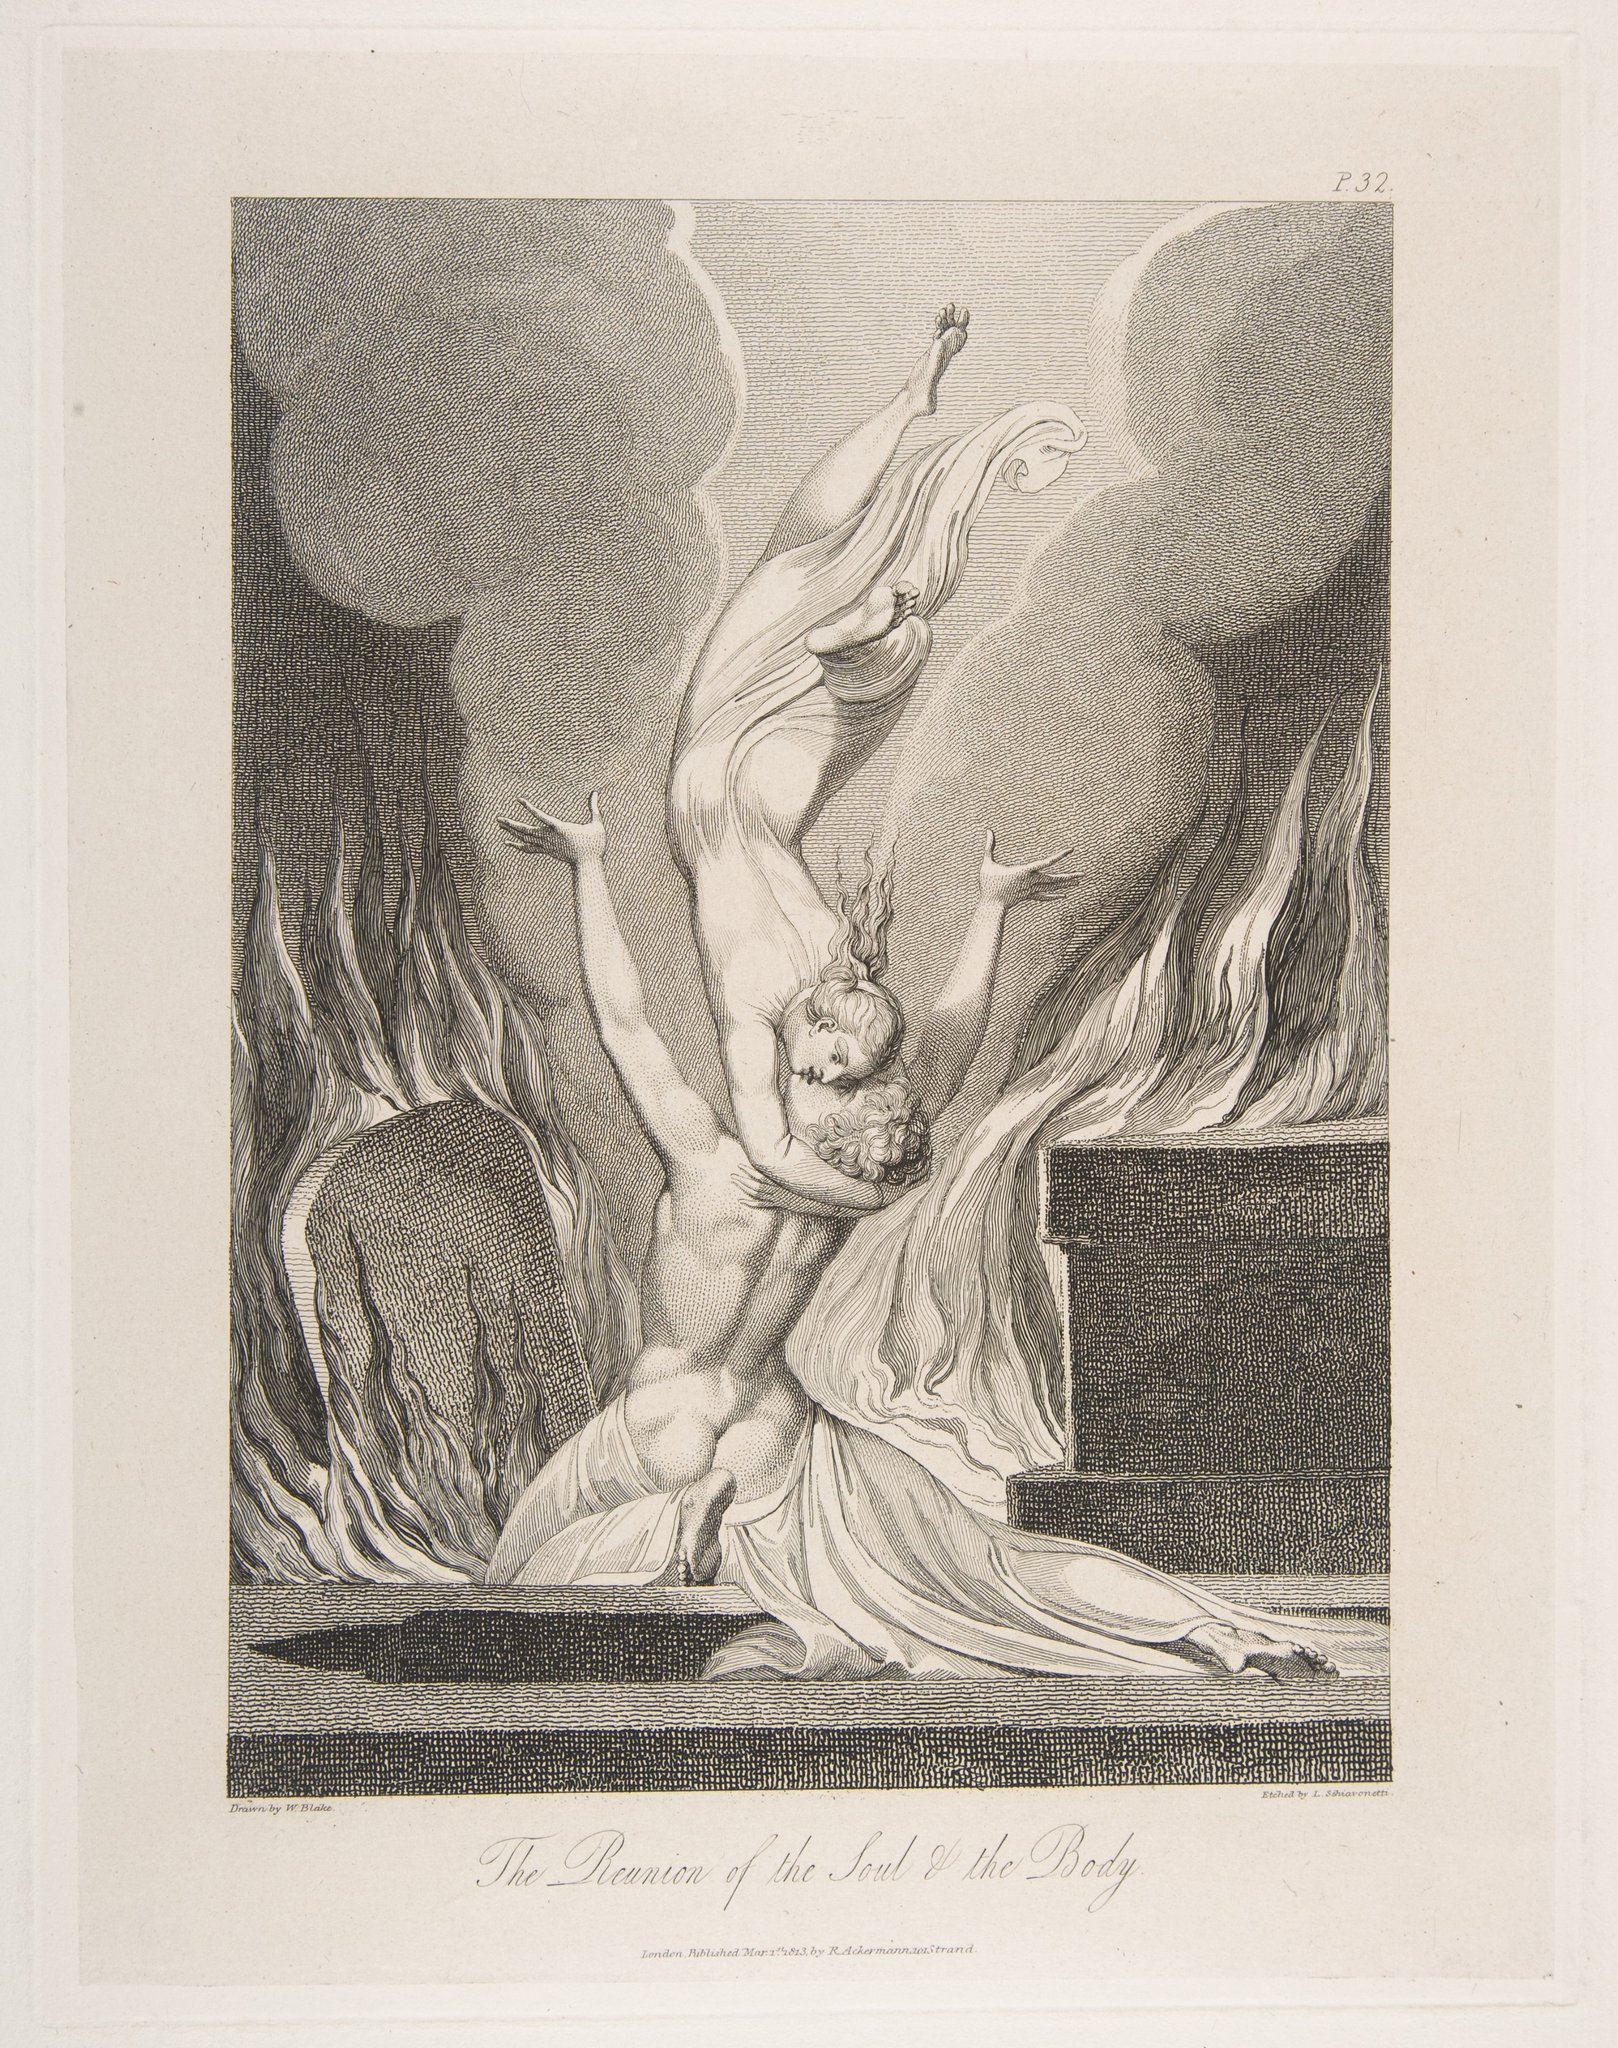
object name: print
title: The Reunion of the Soul & the Body, from "The Grave," a Poem by Robert Blair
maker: william blake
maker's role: artist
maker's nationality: british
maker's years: 1757-1827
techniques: engraving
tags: men,women